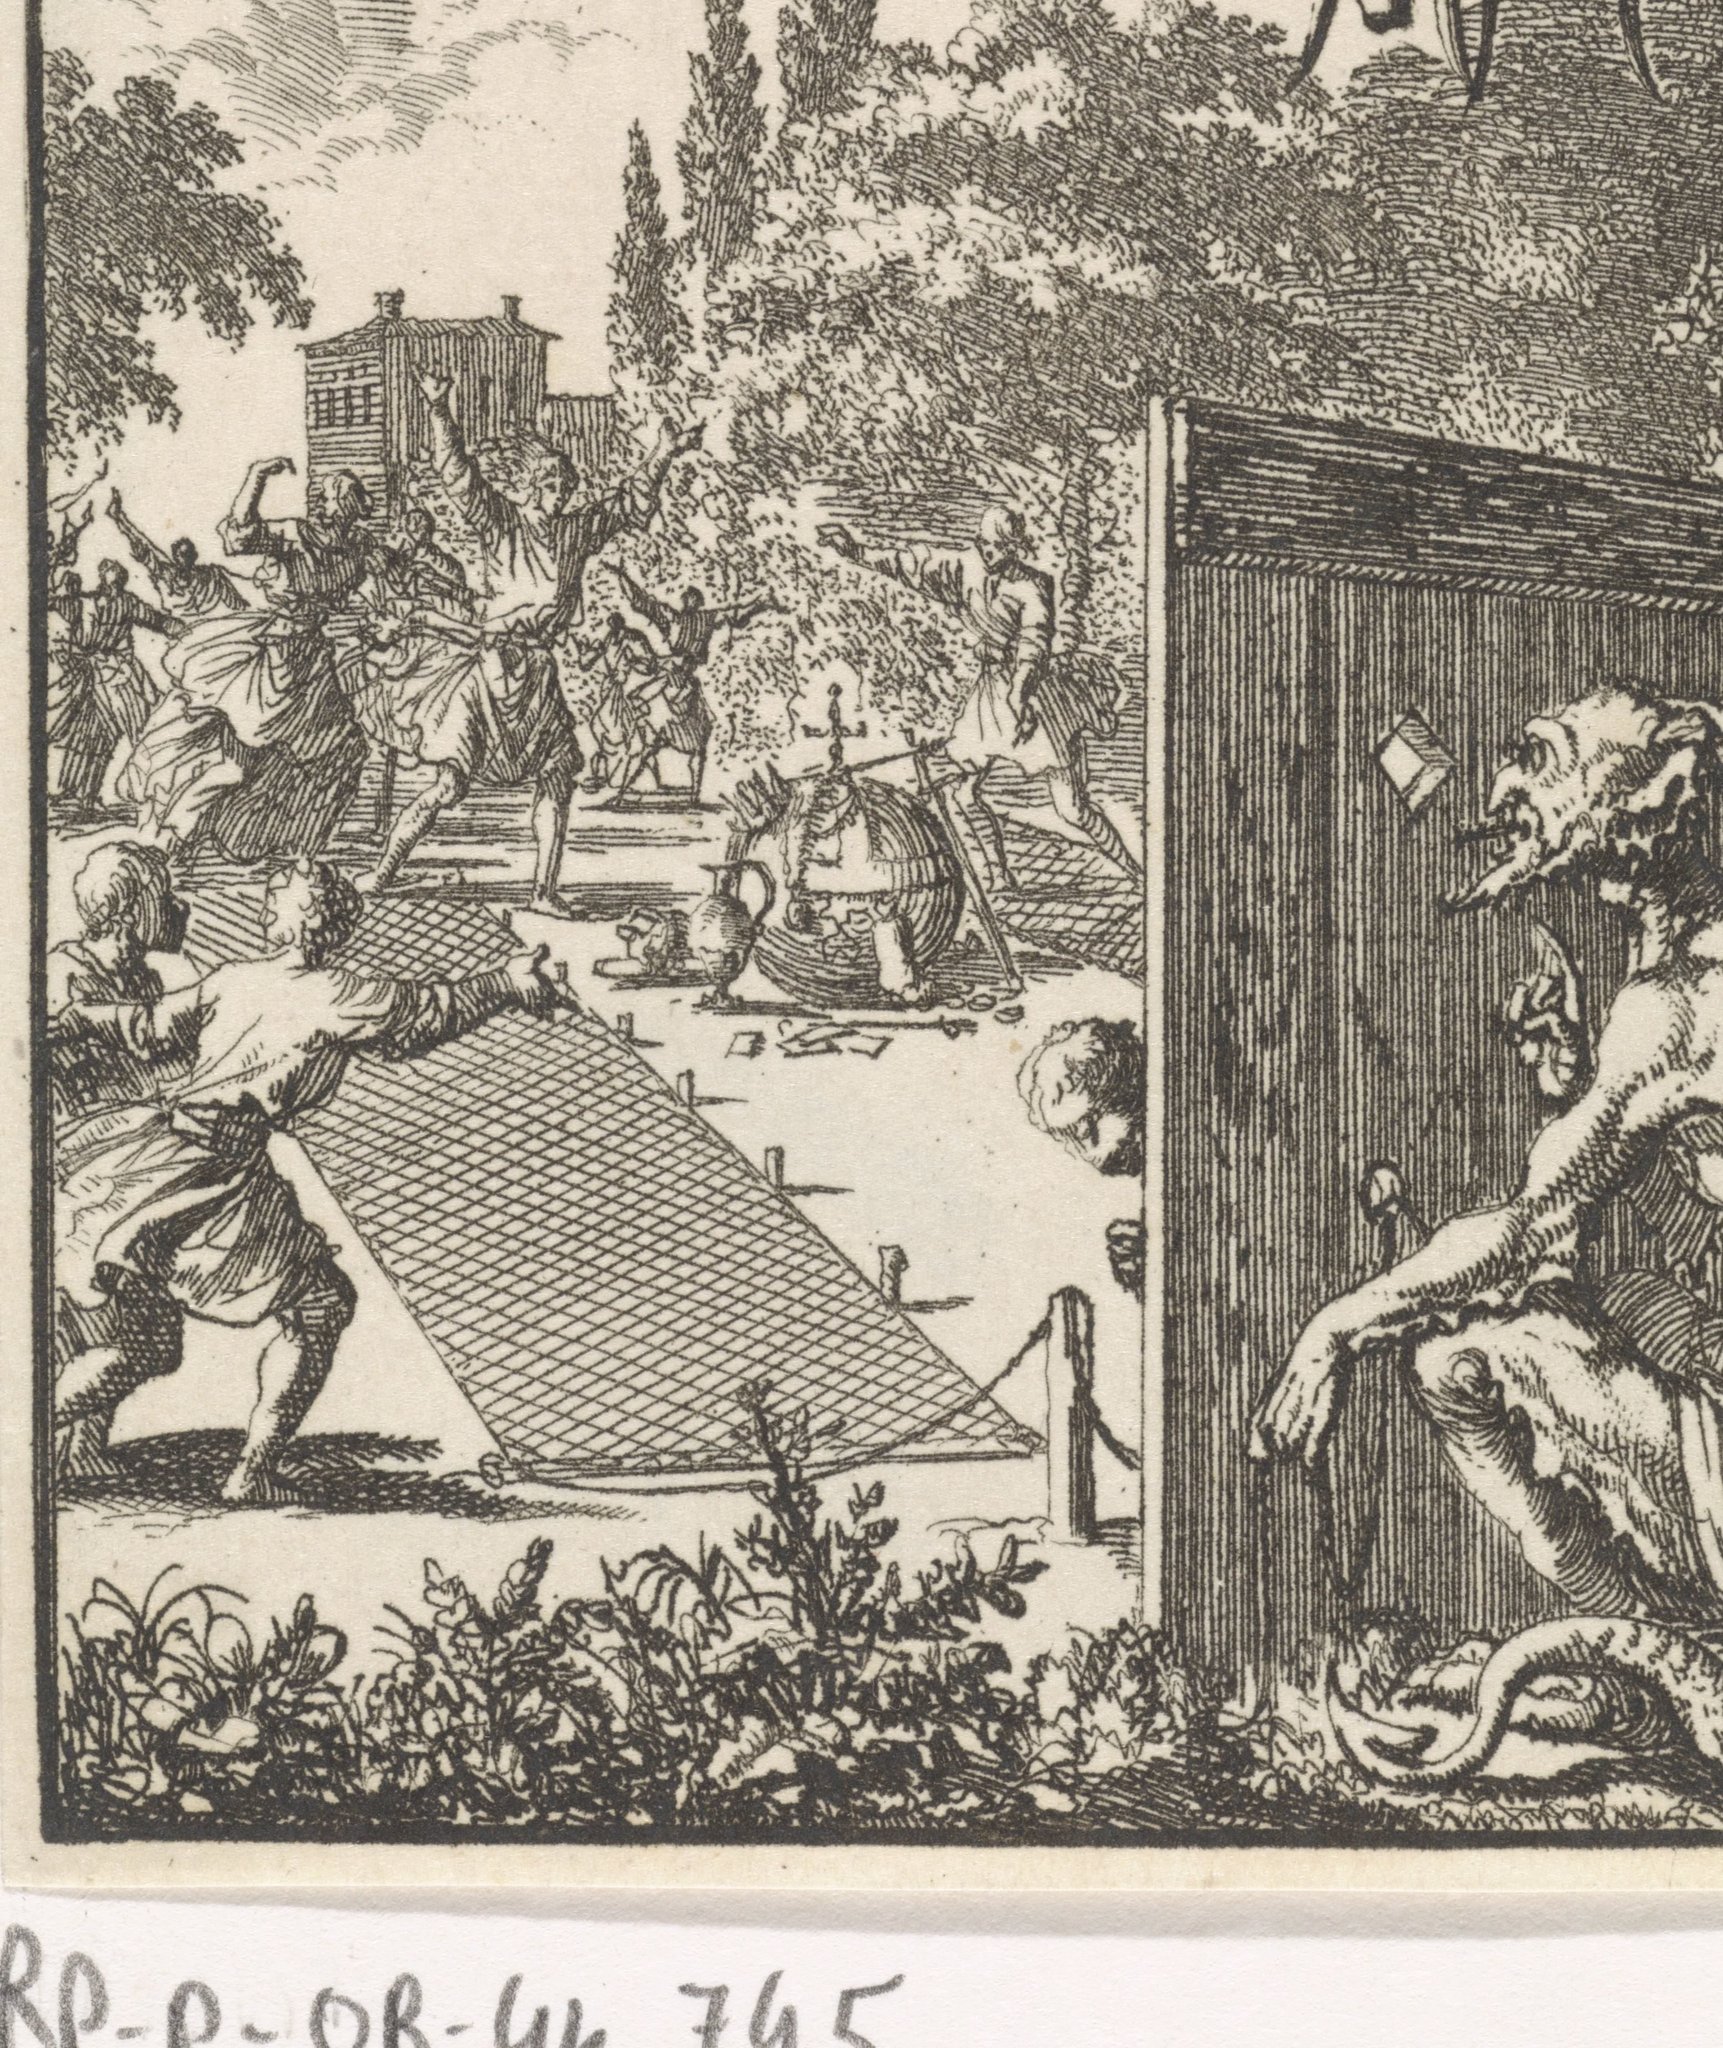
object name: print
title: Satan als vogelvanger met wereldse rijkdom als aas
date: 1699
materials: paper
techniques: etching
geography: amsterdam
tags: devil(s) and demons, bird hunting (+ net), 'mondo', 'machina del mondo' (ripa), acquiring riches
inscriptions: collector's mark: Lugt 2228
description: Op de voorgrond zit de duivel achter een muurtje met in zijn handen een koord dat aan een vangnet is vastgemaakt. Op de achtergrond rennen mensen richting een wereldbol met allerlei rijkdommen. De mensen zijn zich niet bewust van het vangnet dat rond de wereldbol is gespannen. Wereldse rijkdom is het aas de de duivel gebruikt om mensen te vangen.